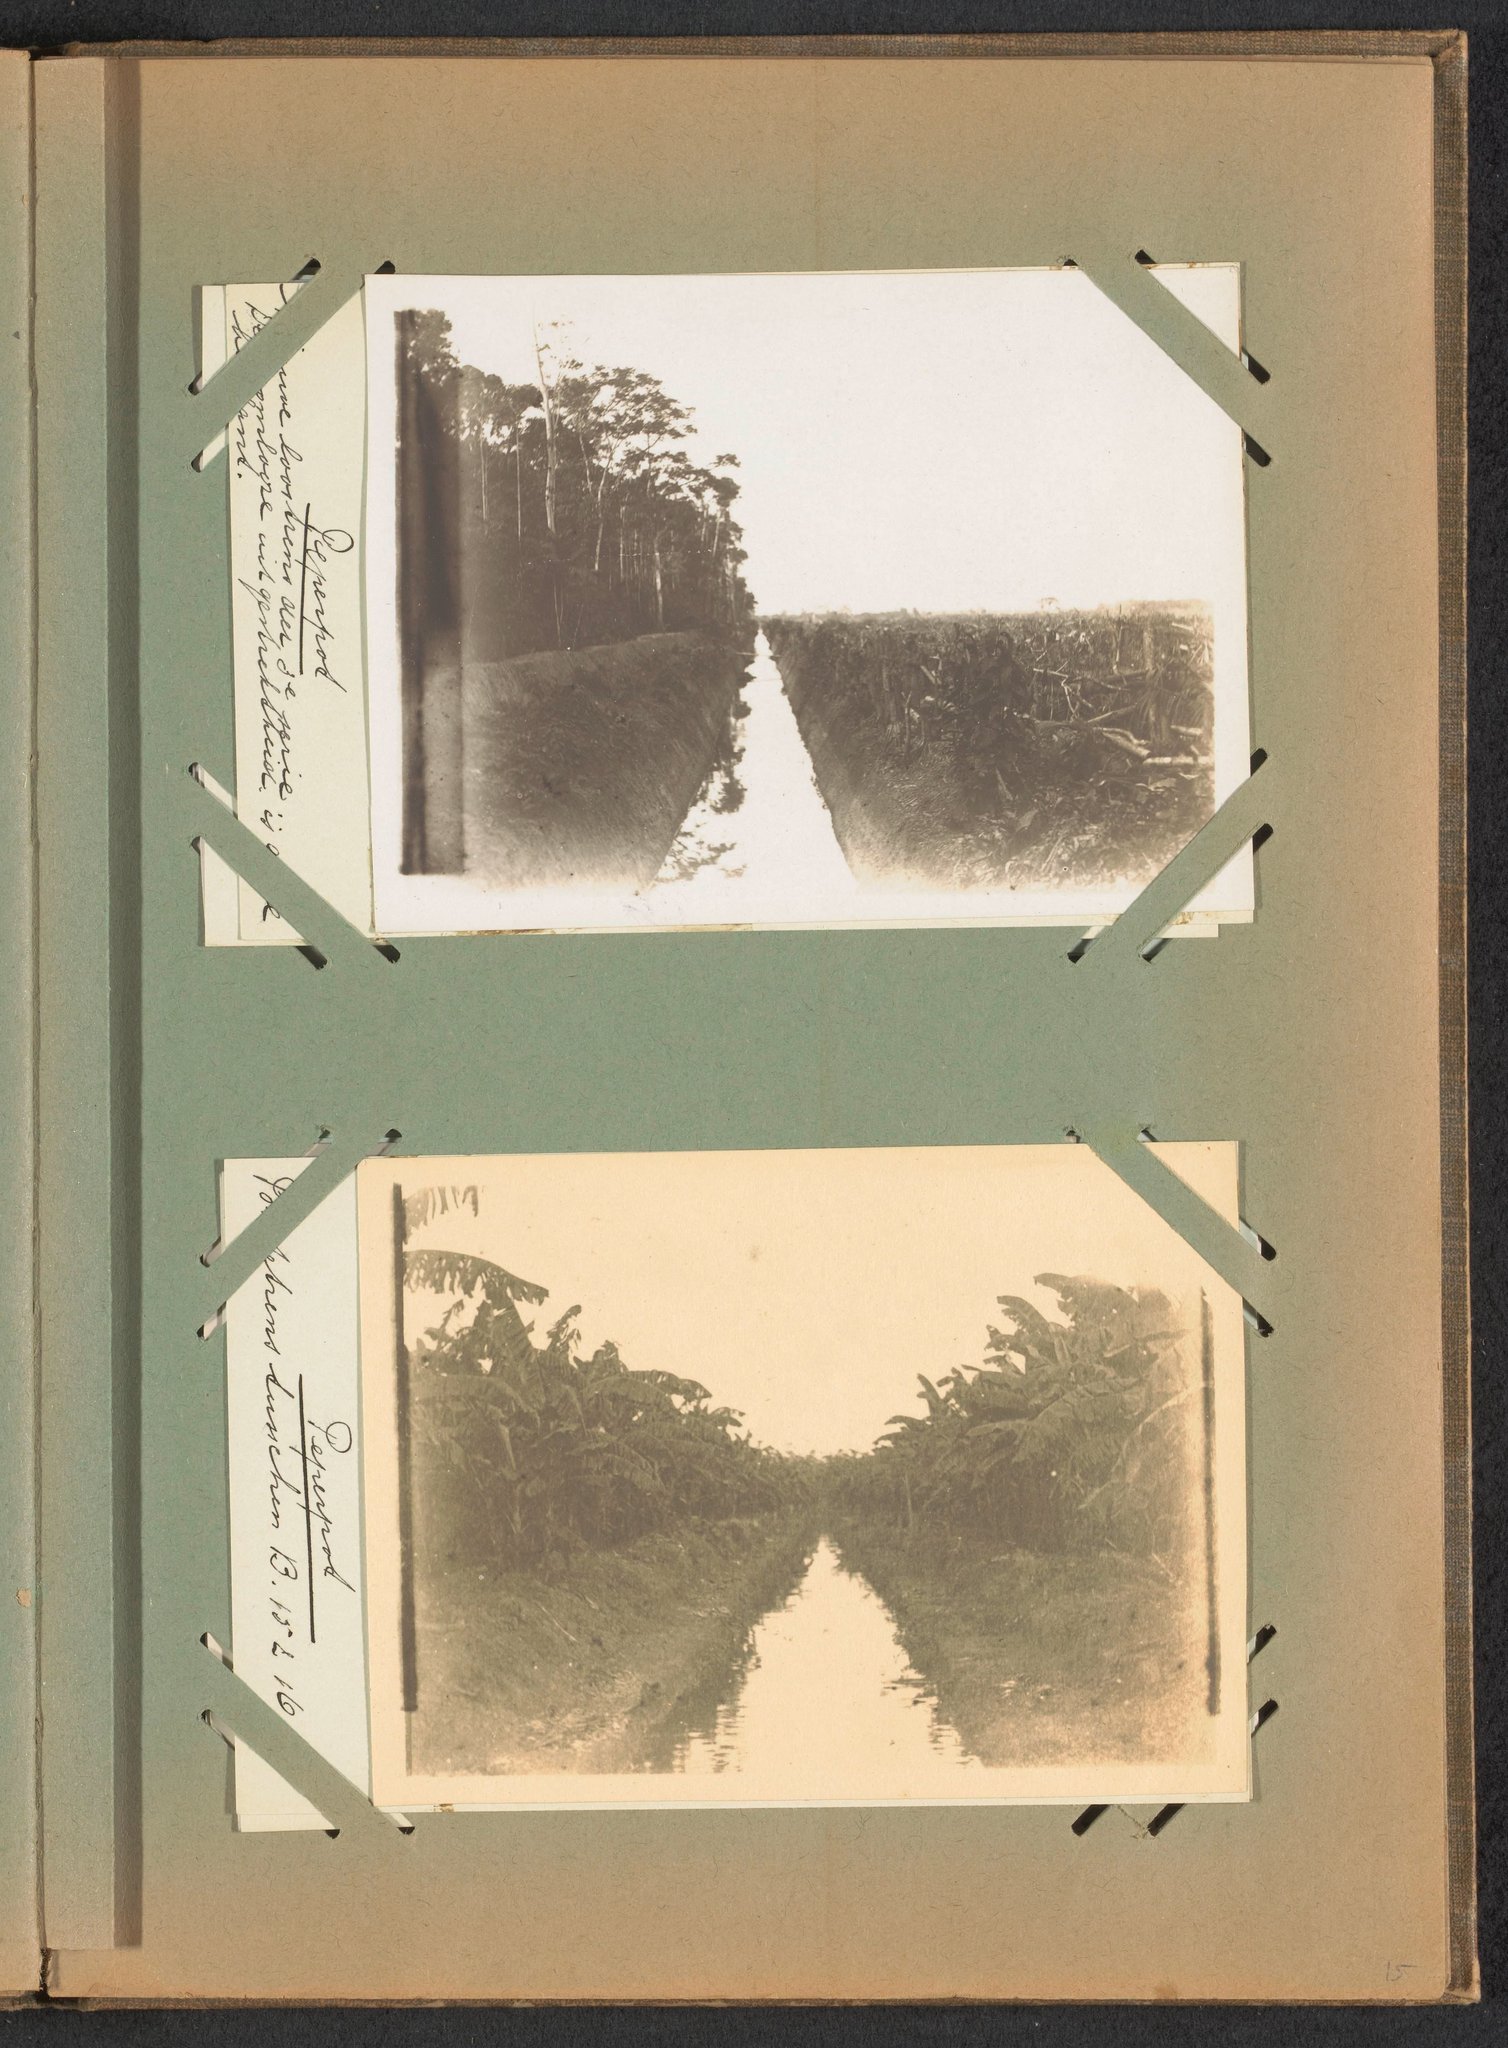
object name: photograph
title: Bananenbomen op Plantage Peperpot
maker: Anonymous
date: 1912-1913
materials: paper, photographic support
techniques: gelatin silver print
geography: suriname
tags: plantation, fruits: banana, suriname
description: Vaart tussen percelen met bananenbomen op Plantage Peperpot in Suriname. Onderdeel van het fotoalbum uit ca. 1912-1913 met 92 foto's van de plantages Peperpot en Dordrecht in Suriname en Mount Pleasant op Curaçao.